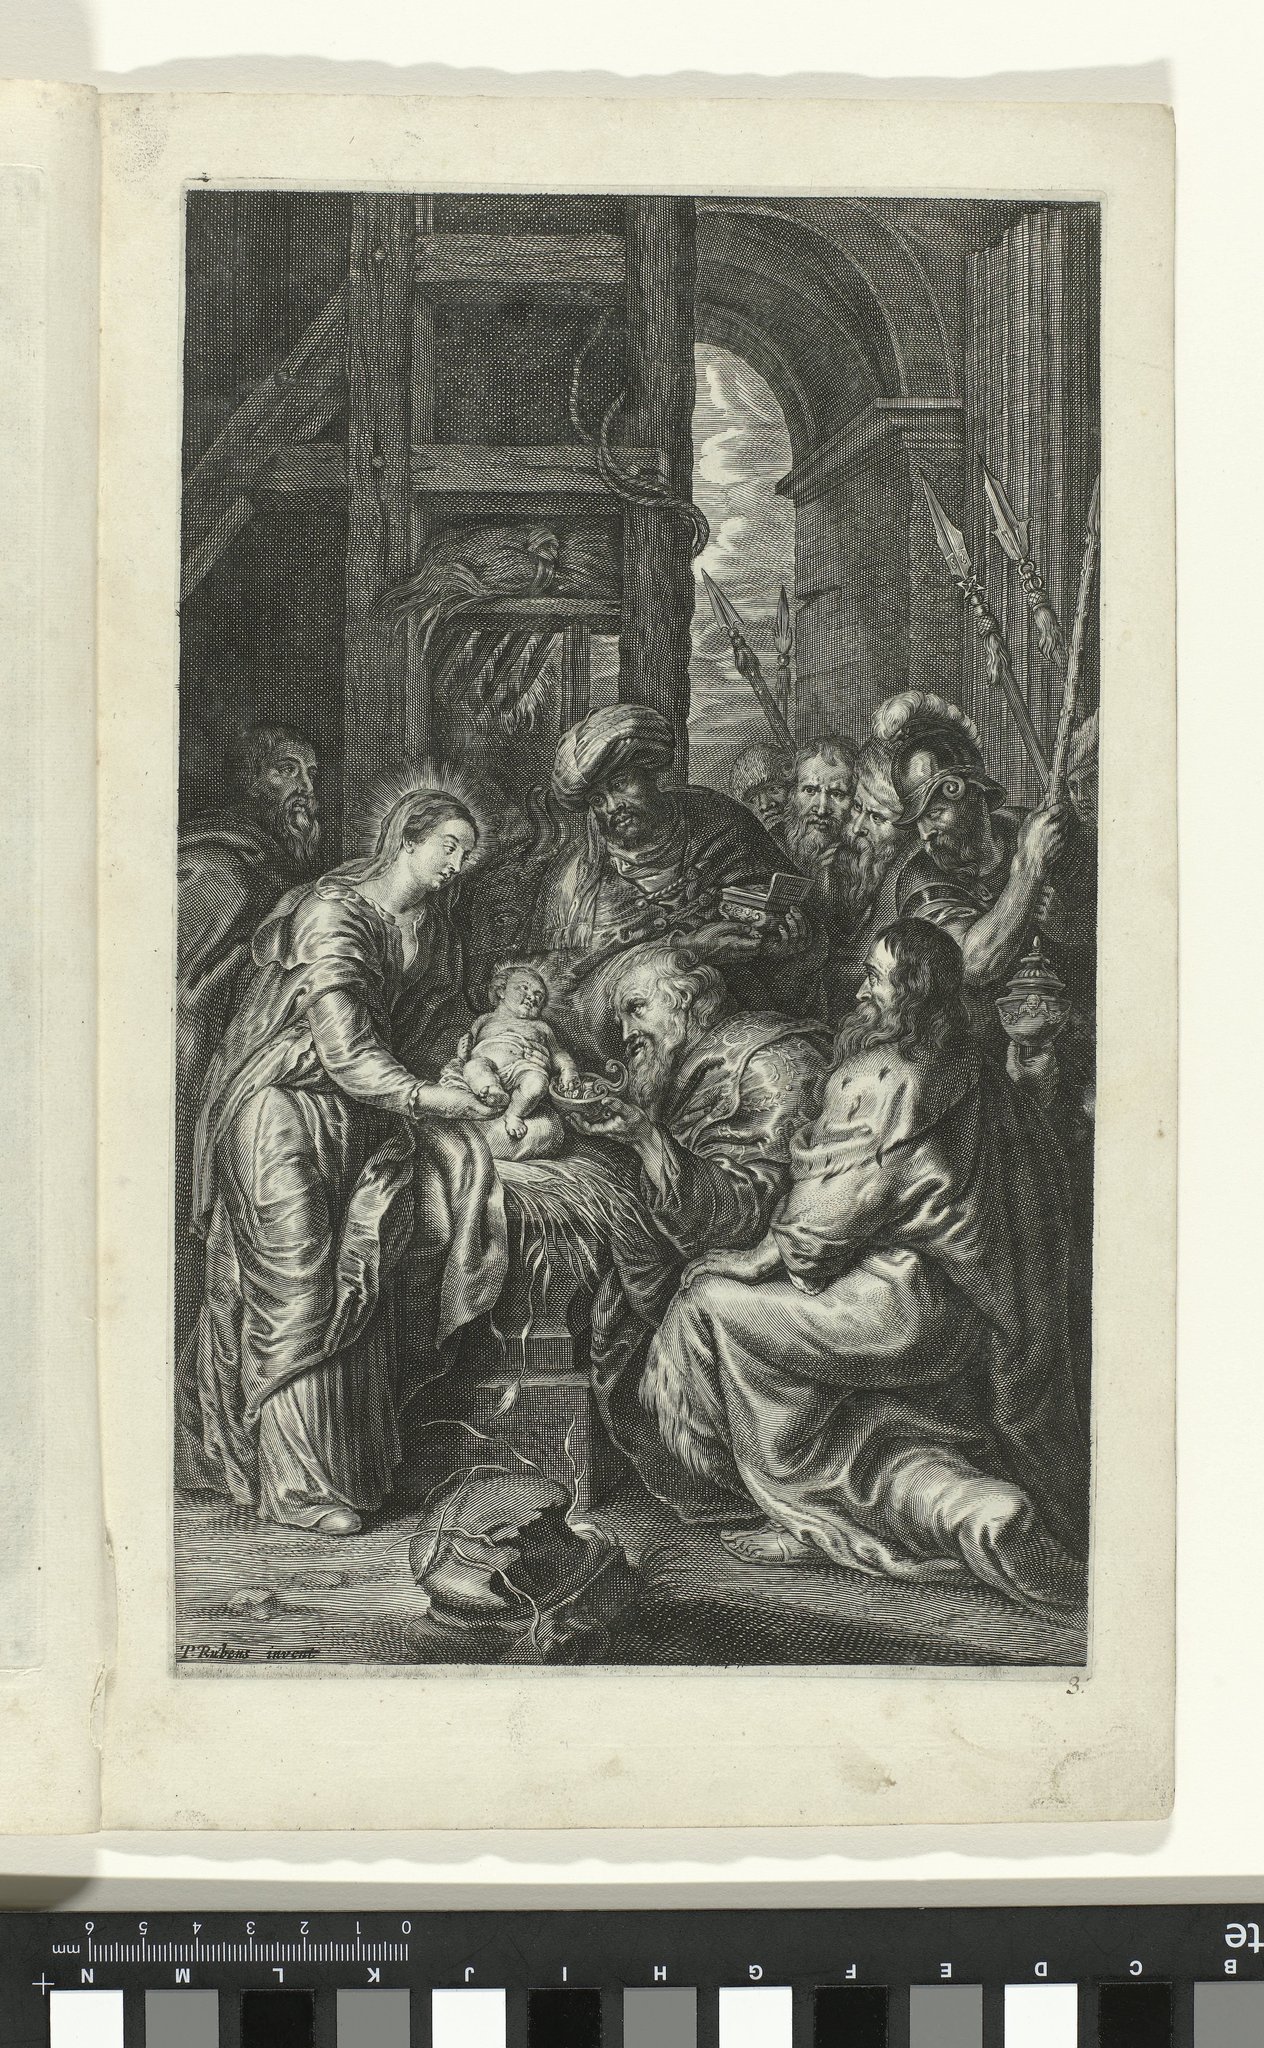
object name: album leaf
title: Leven van Christus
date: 1600-1652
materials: paper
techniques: engraving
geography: antwerp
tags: adoration of the kings: the wise men present their gifts to the christ-child (gold, frankincense and myrrh)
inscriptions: collector's mark: Lugt 2228, collector's mark: Lugt 2760, inscription: ‘3’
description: In een schuur toont Maria het kind aan de drie koningen. Jozef staat achter haar. De koningen hebben geschenken in de hand en zijn vergezeld van soldaten. De prent maakt deel uit van een album.